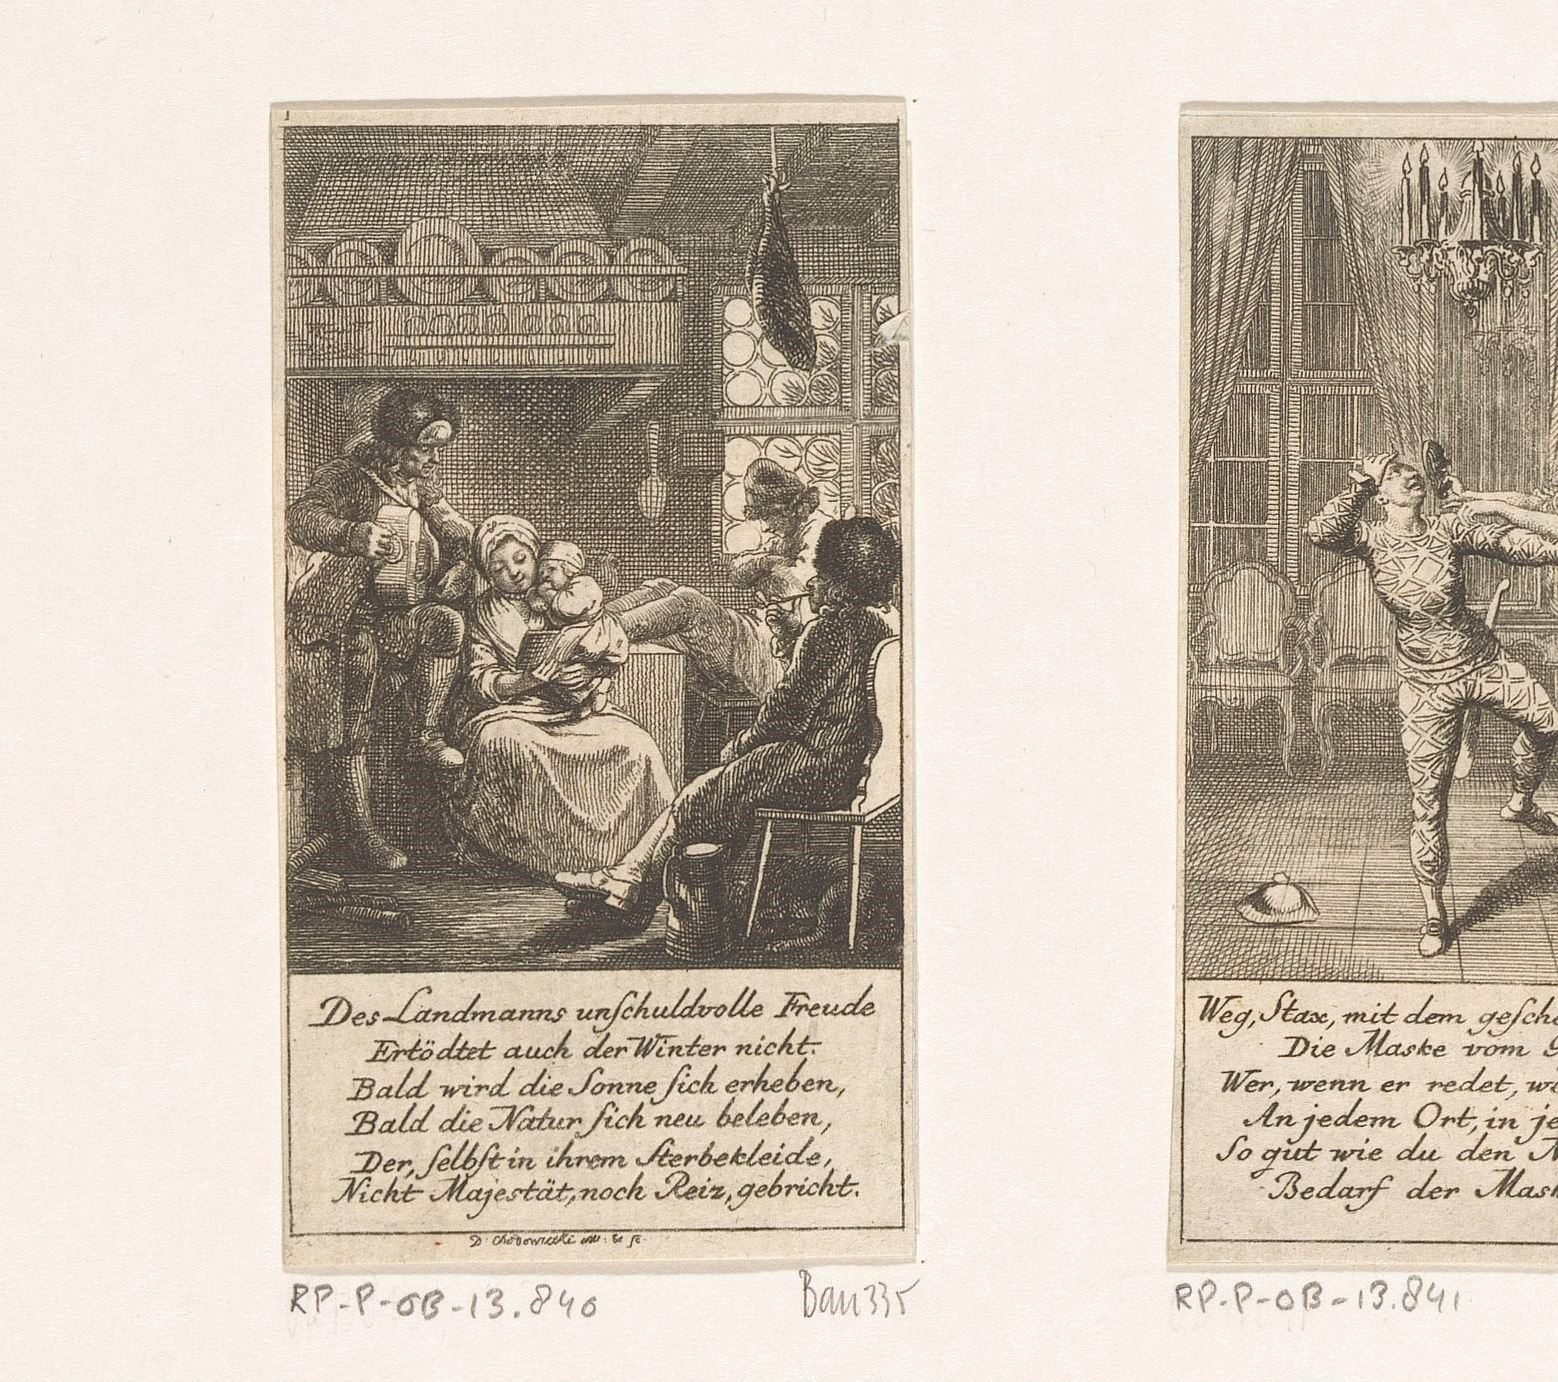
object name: print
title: Januari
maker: daniel nikolaus chodowiecki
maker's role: draughtsman, print maker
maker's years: 1726-1801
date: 1777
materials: paper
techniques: etching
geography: berlin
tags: accordion, january and its 'labours', reading to somebody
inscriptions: collector's mark: Lugt 2228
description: Afkomstig uit een serie met de twaalf maanden. Deze serie werd op een plaat geëtst. Deze serie is ook gebruikt in: Königl. Großbrit. Churf. Braunschw. Lüneb. Genealogischen Kalender, auf das Jahr 1778. Lauenburg: Johann Georg Berenberg.